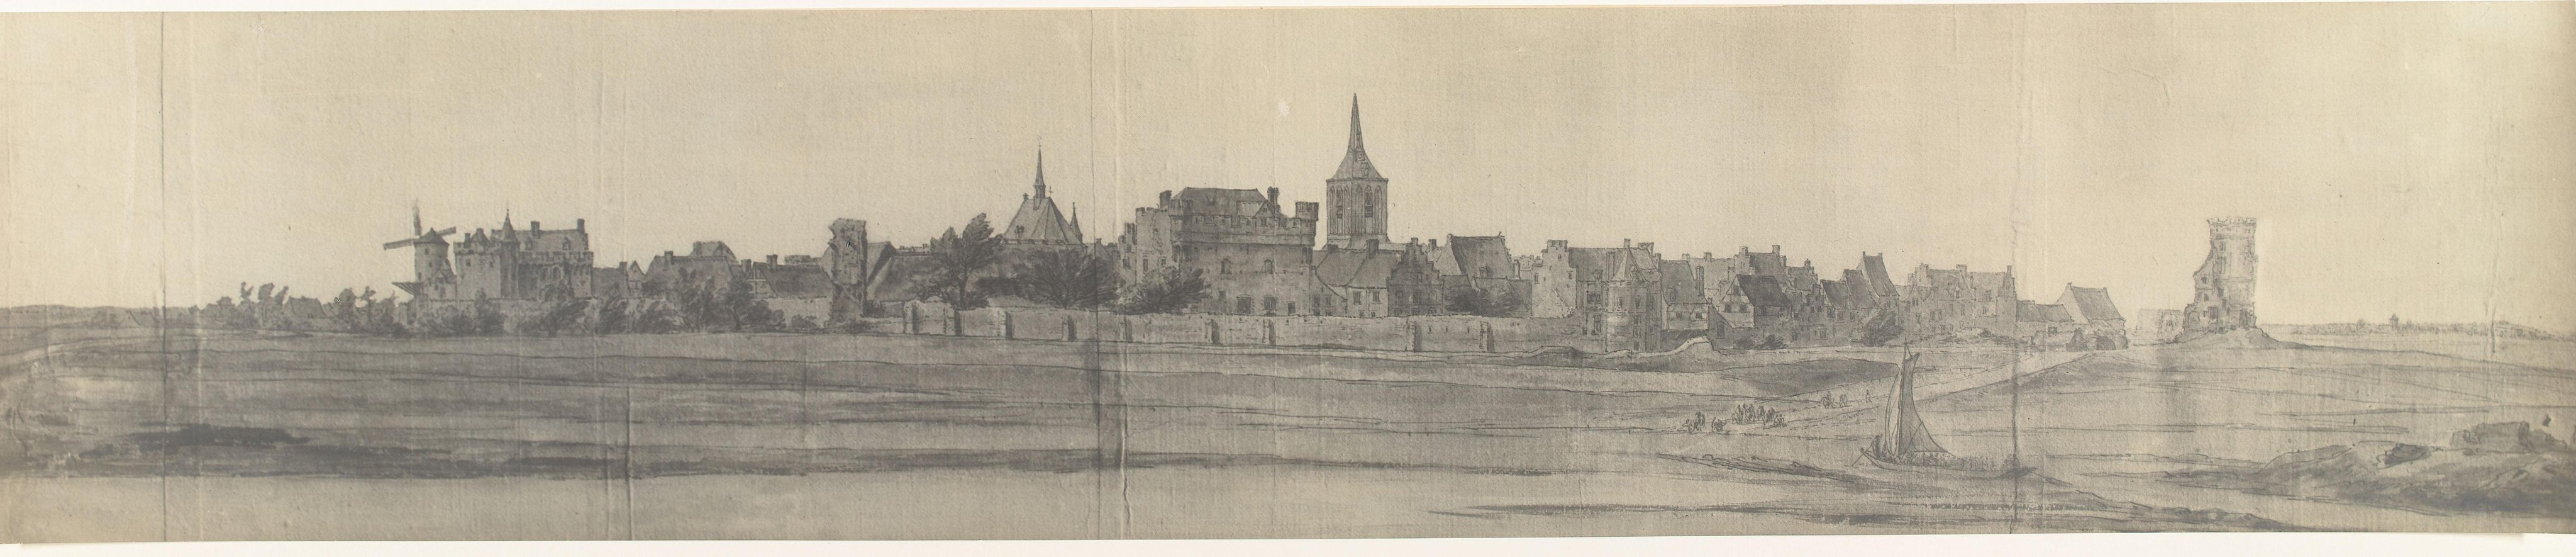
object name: photograph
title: Foto's van tekeningen van de Franse inval in de Nederlanden in 1672 door Adam Frans van der Meulen bewaard in de Manufacture des Gobelins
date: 1900-1903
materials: paper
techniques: gelatin silver print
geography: france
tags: lodewijk xiv (koning van frankrijk), prospect of city, town panorama, silhouette of city, rampjaar (disaster year)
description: Niet in Frederik Muller; door het RPK toegevoegd nummer. Onderdeel van een groep van ca. 50 foto's van tekeningen van de Franse inval in de Nederlanden in 1672 door Adam Frans van der Meulen, bewaard in de Manufacture Nationale des Gobelins te Parijs.